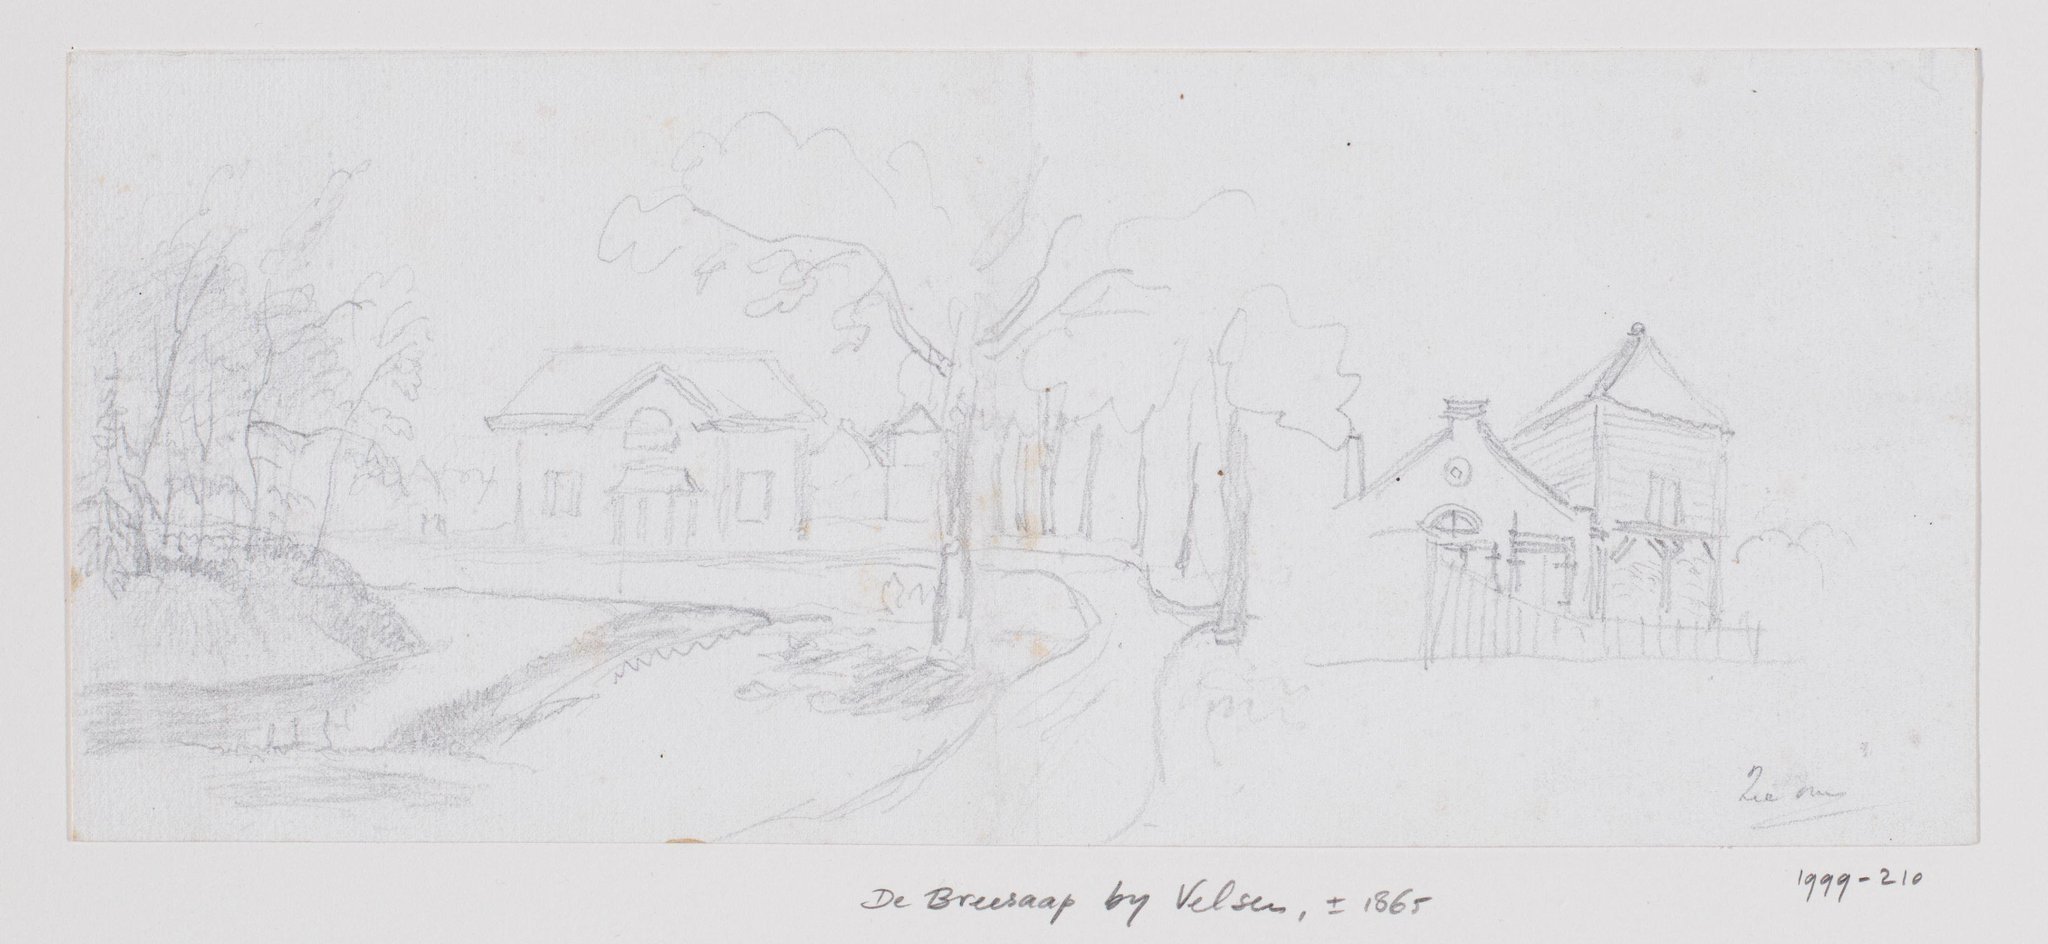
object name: topographical view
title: De Breesaap bij Velsen, Noord-Holland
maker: adrianus johannes bik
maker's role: draughtsman, print maker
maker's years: 1790-1872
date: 1865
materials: chalk, paper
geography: velsen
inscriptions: annotation: ‘Schets aangevende het Hof / op de Breesap / by Velzen / moet zijn ongeveer 1865; zie om’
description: artikel over deze collectie in Bulletin van het Rijksmuseum 49 [2001], nr. 4, pp.343 e.v.